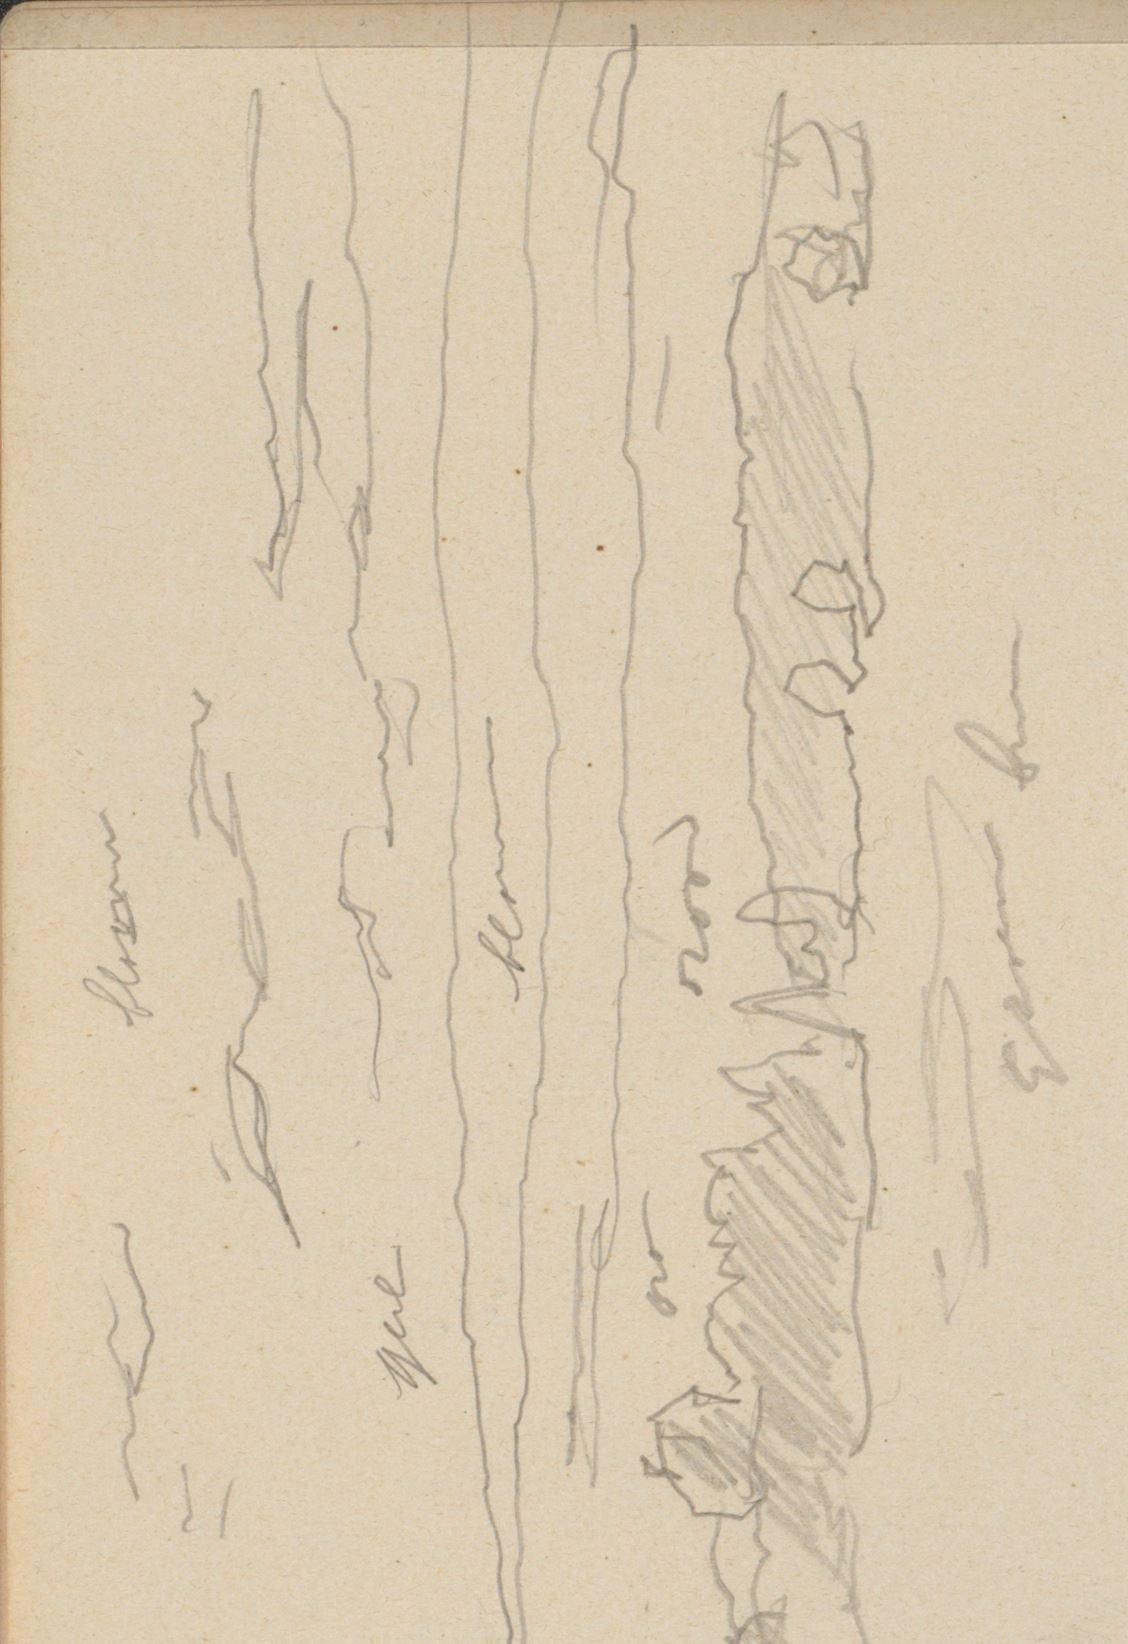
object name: sketchbook leaf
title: Landschap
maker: george hendrik breitner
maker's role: draughtsman, painter, print maker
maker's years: 1857-1923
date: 1915-1916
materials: paper, pencil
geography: netherlands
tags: landscapes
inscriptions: kleurnotitie, handgeschreven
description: Pagina 17 uit een schetsboek met 43 bladen.